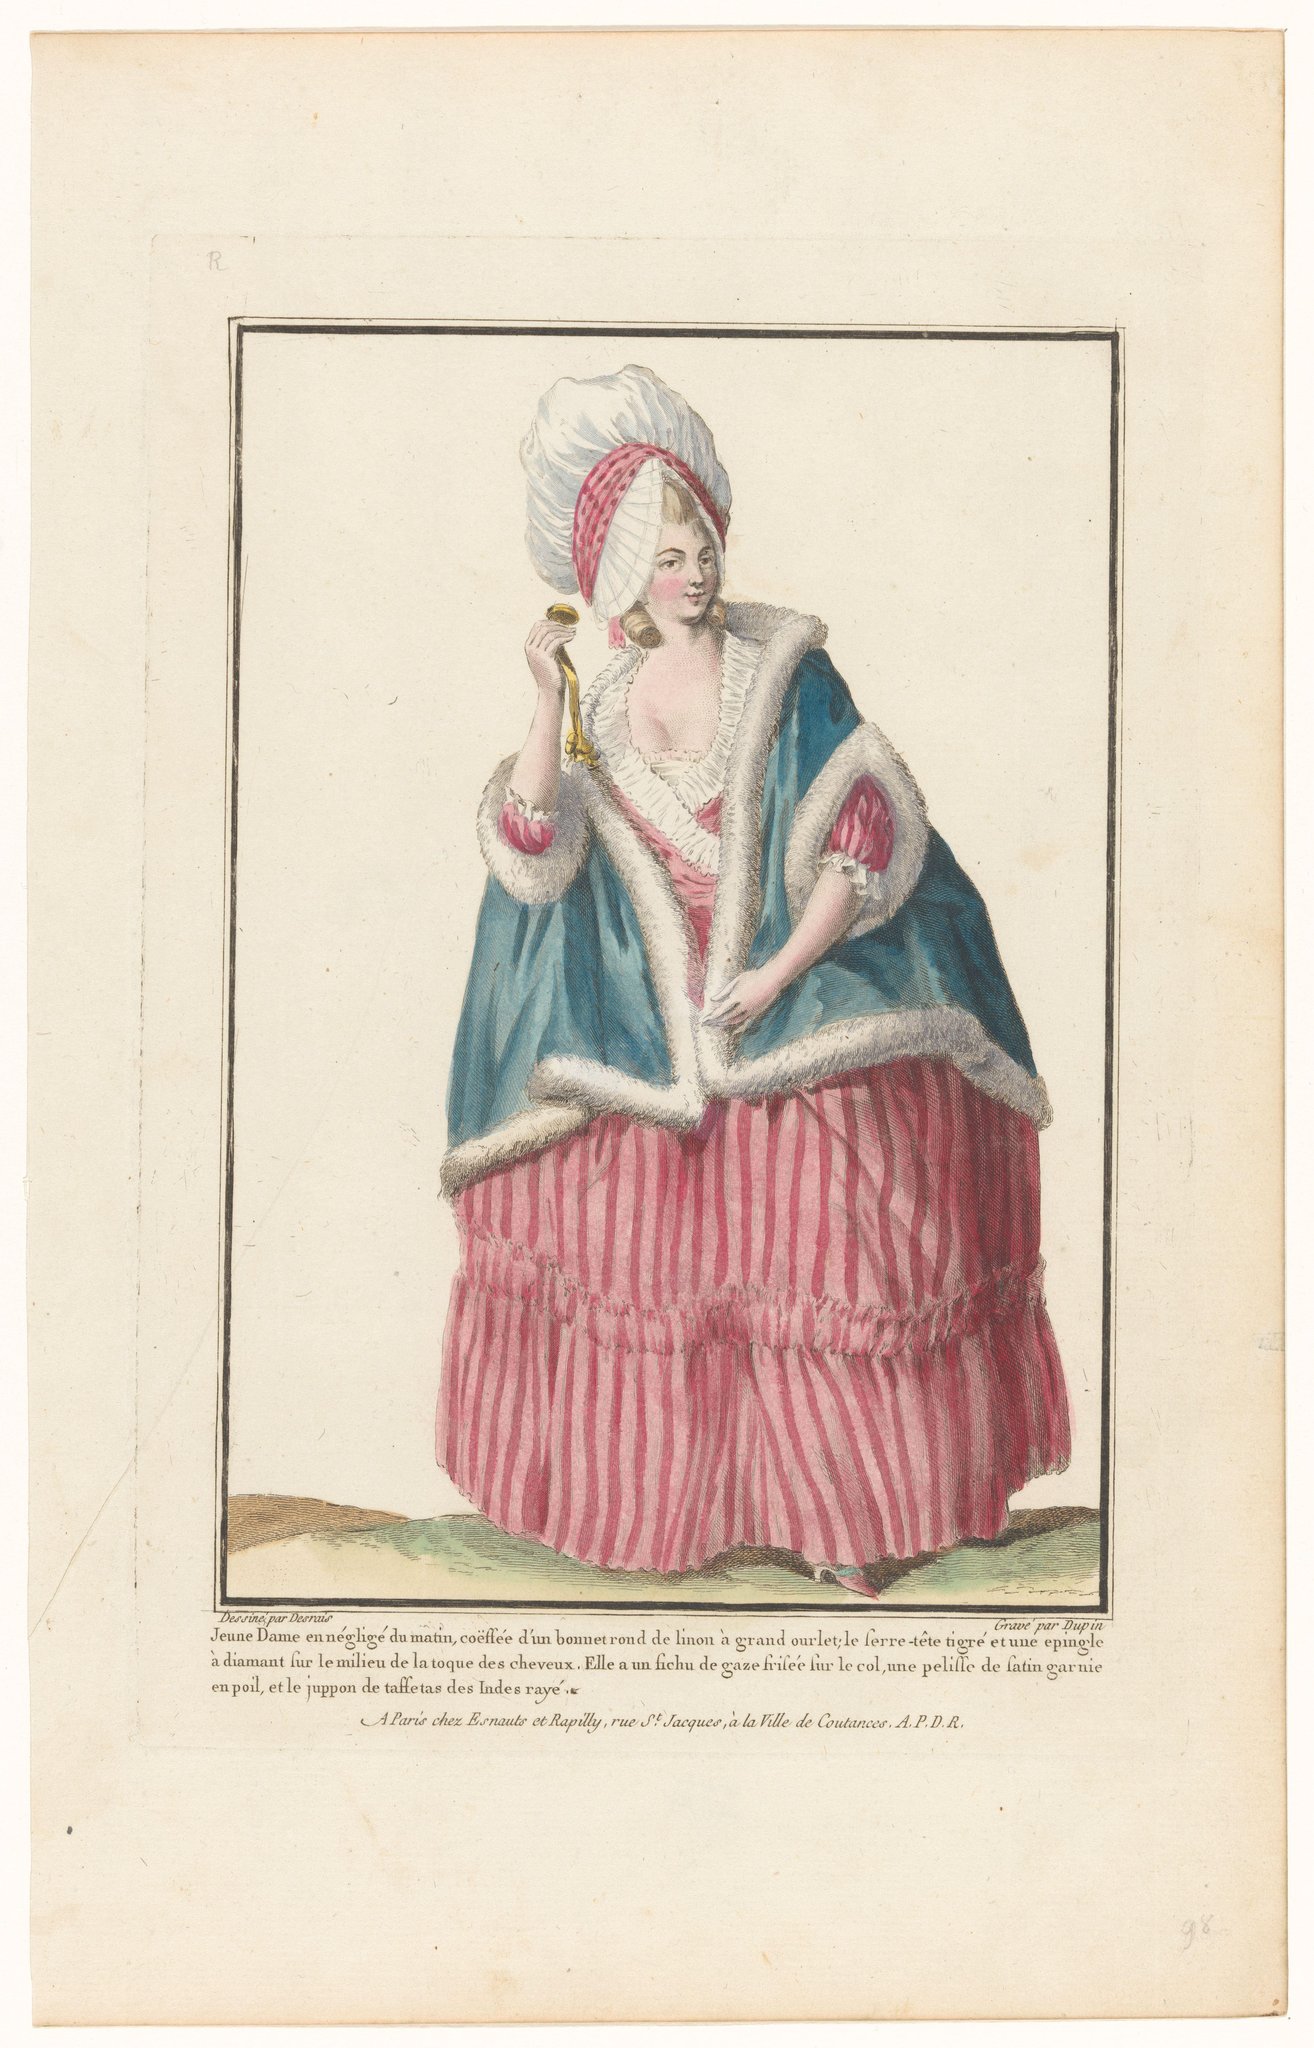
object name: fashion print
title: Gallerie des Modes et Costumes Français, 1779, R. 98: Jeune dame en négligé du matin (...)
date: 1779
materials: paper, ink, watercolor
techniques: engraving, etching, hand coloring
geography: paris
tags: dress, gown: morning dress (+ women's clothes), fibula, safety pin (+ women's clothes), cape (pelisse) (+ women's clothes), fashion plates, shoes, sandals (+ women's clothes), piece of clothing covering the breast or décolleté (fichu) (+ women's clothes)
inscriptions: title (possibly false): ‘Jeune dame en négligé du matin, coëffée d'un bonnet rond de linon à grand ourlet; le serre-tête tigré et un épingle à diamant sur le milieu de la toque des cheveux. Elle a un fichu de gaze frisée sur le col, une pelisse de satin garnie en poil, et le juppon de taffetas des Indes rayé’, collector's mark: Lugt 2228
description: Jonge vrouw in ochtendnégligé, bestaande uit een pelisse van satijn, afgezet met een bontrand, over een japon van roze gestreepte tafzijde. Fichu van geplooide gaze. Een grote ronde linnen muts over het hoge kapsel. Prent uit serie R. 17e Cahier de Costumes Français, 11e Suite d'Habillemens à la mode en 1779, Gallerie des Modes et Costumes Français.